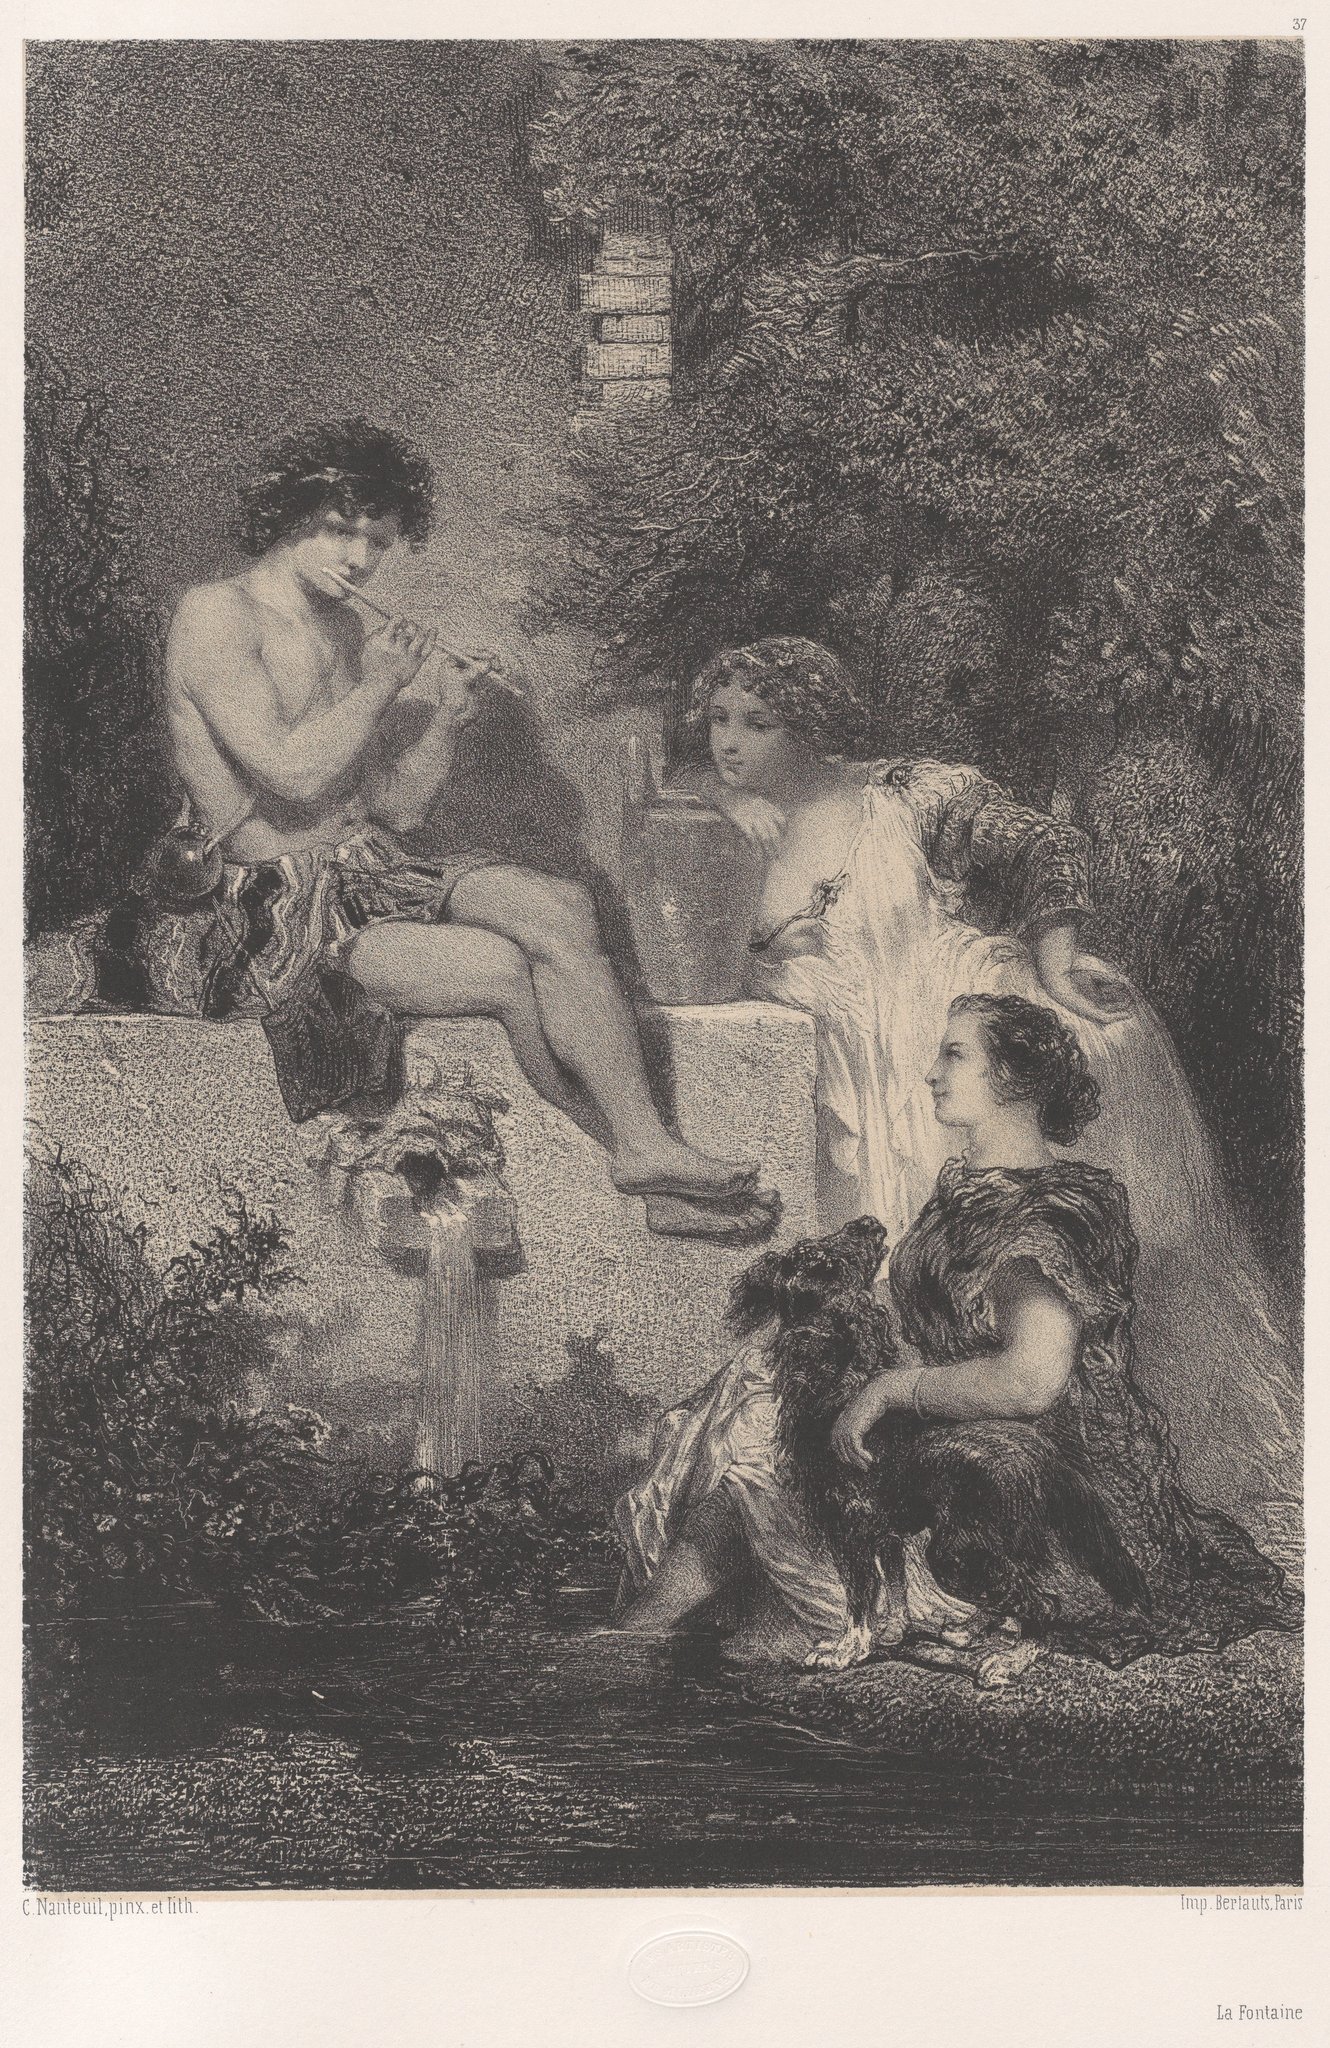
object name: print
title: The Fountain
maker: célestin nanteuil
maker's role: artist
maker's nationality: french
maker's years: 1813-1873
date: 1830-1870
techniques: lithograph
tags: musical instruments,men,women,dogs